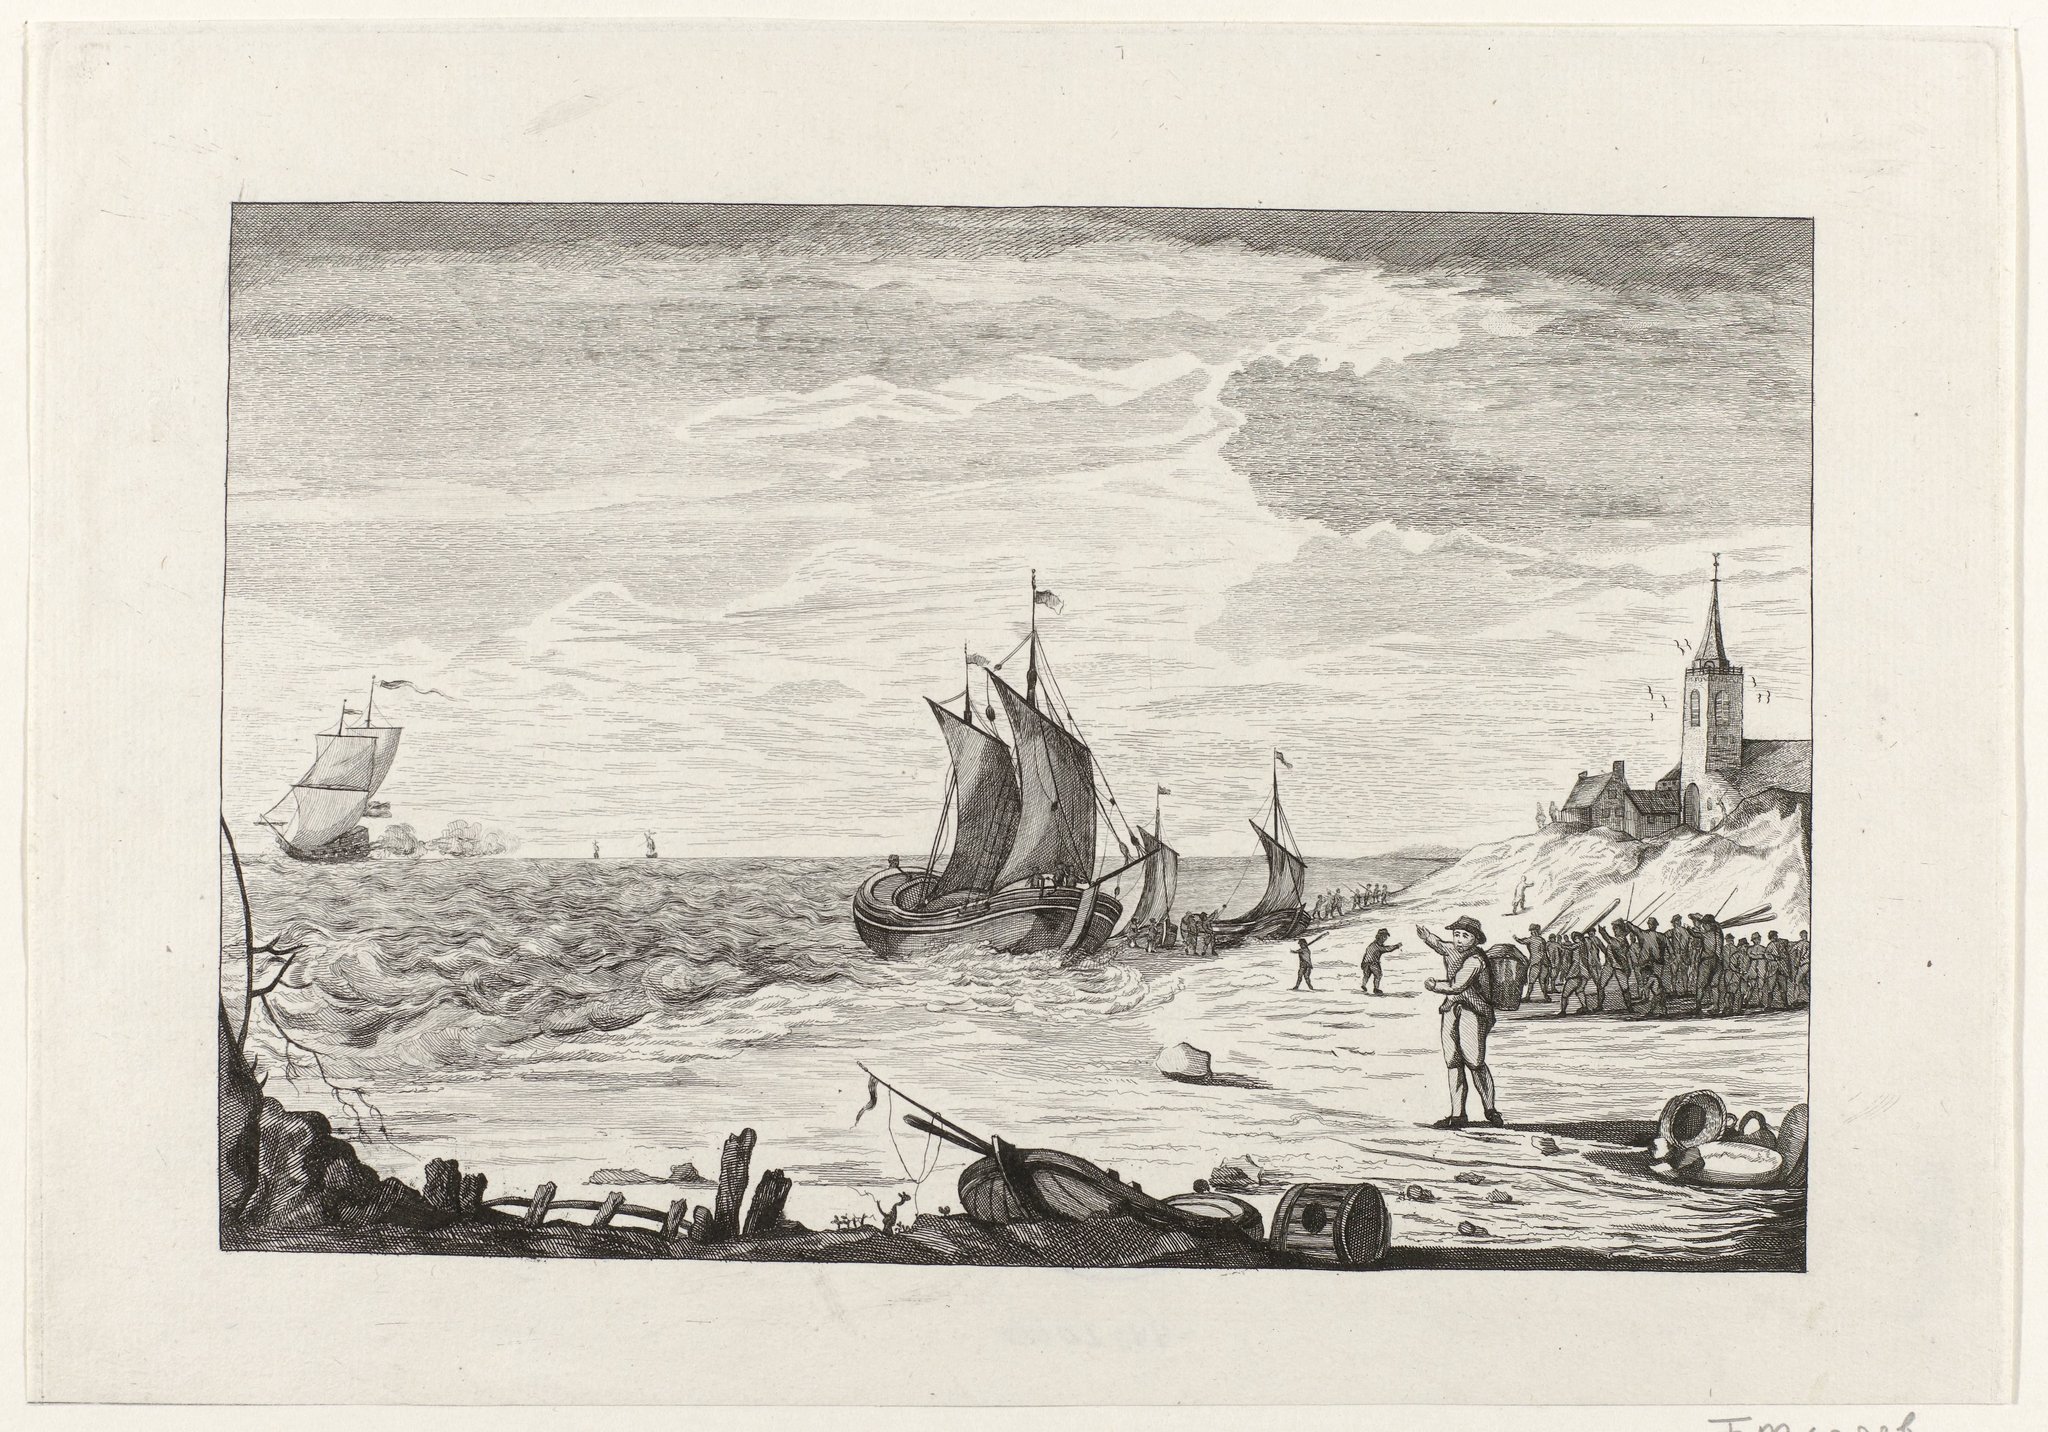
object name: print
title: Vlaardinger hoeker door de Engelsen op het strand gejaagd, 1781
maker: arend fokke willemsz.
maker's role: print maker, publisher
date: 1781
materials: paper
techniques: etching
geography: northern netherlands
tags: wreck ashore, fourth anglo-dutch war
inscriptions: collector's mark: Lugt 2228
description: Een Vlaardinger hoeker tijdens het vissen door Engelse kapers het strand bij Scheveningen opgejaagd, 7 januari 1781. Het strand bij Scheveningen met een woedende menigte bij het vissersschip.